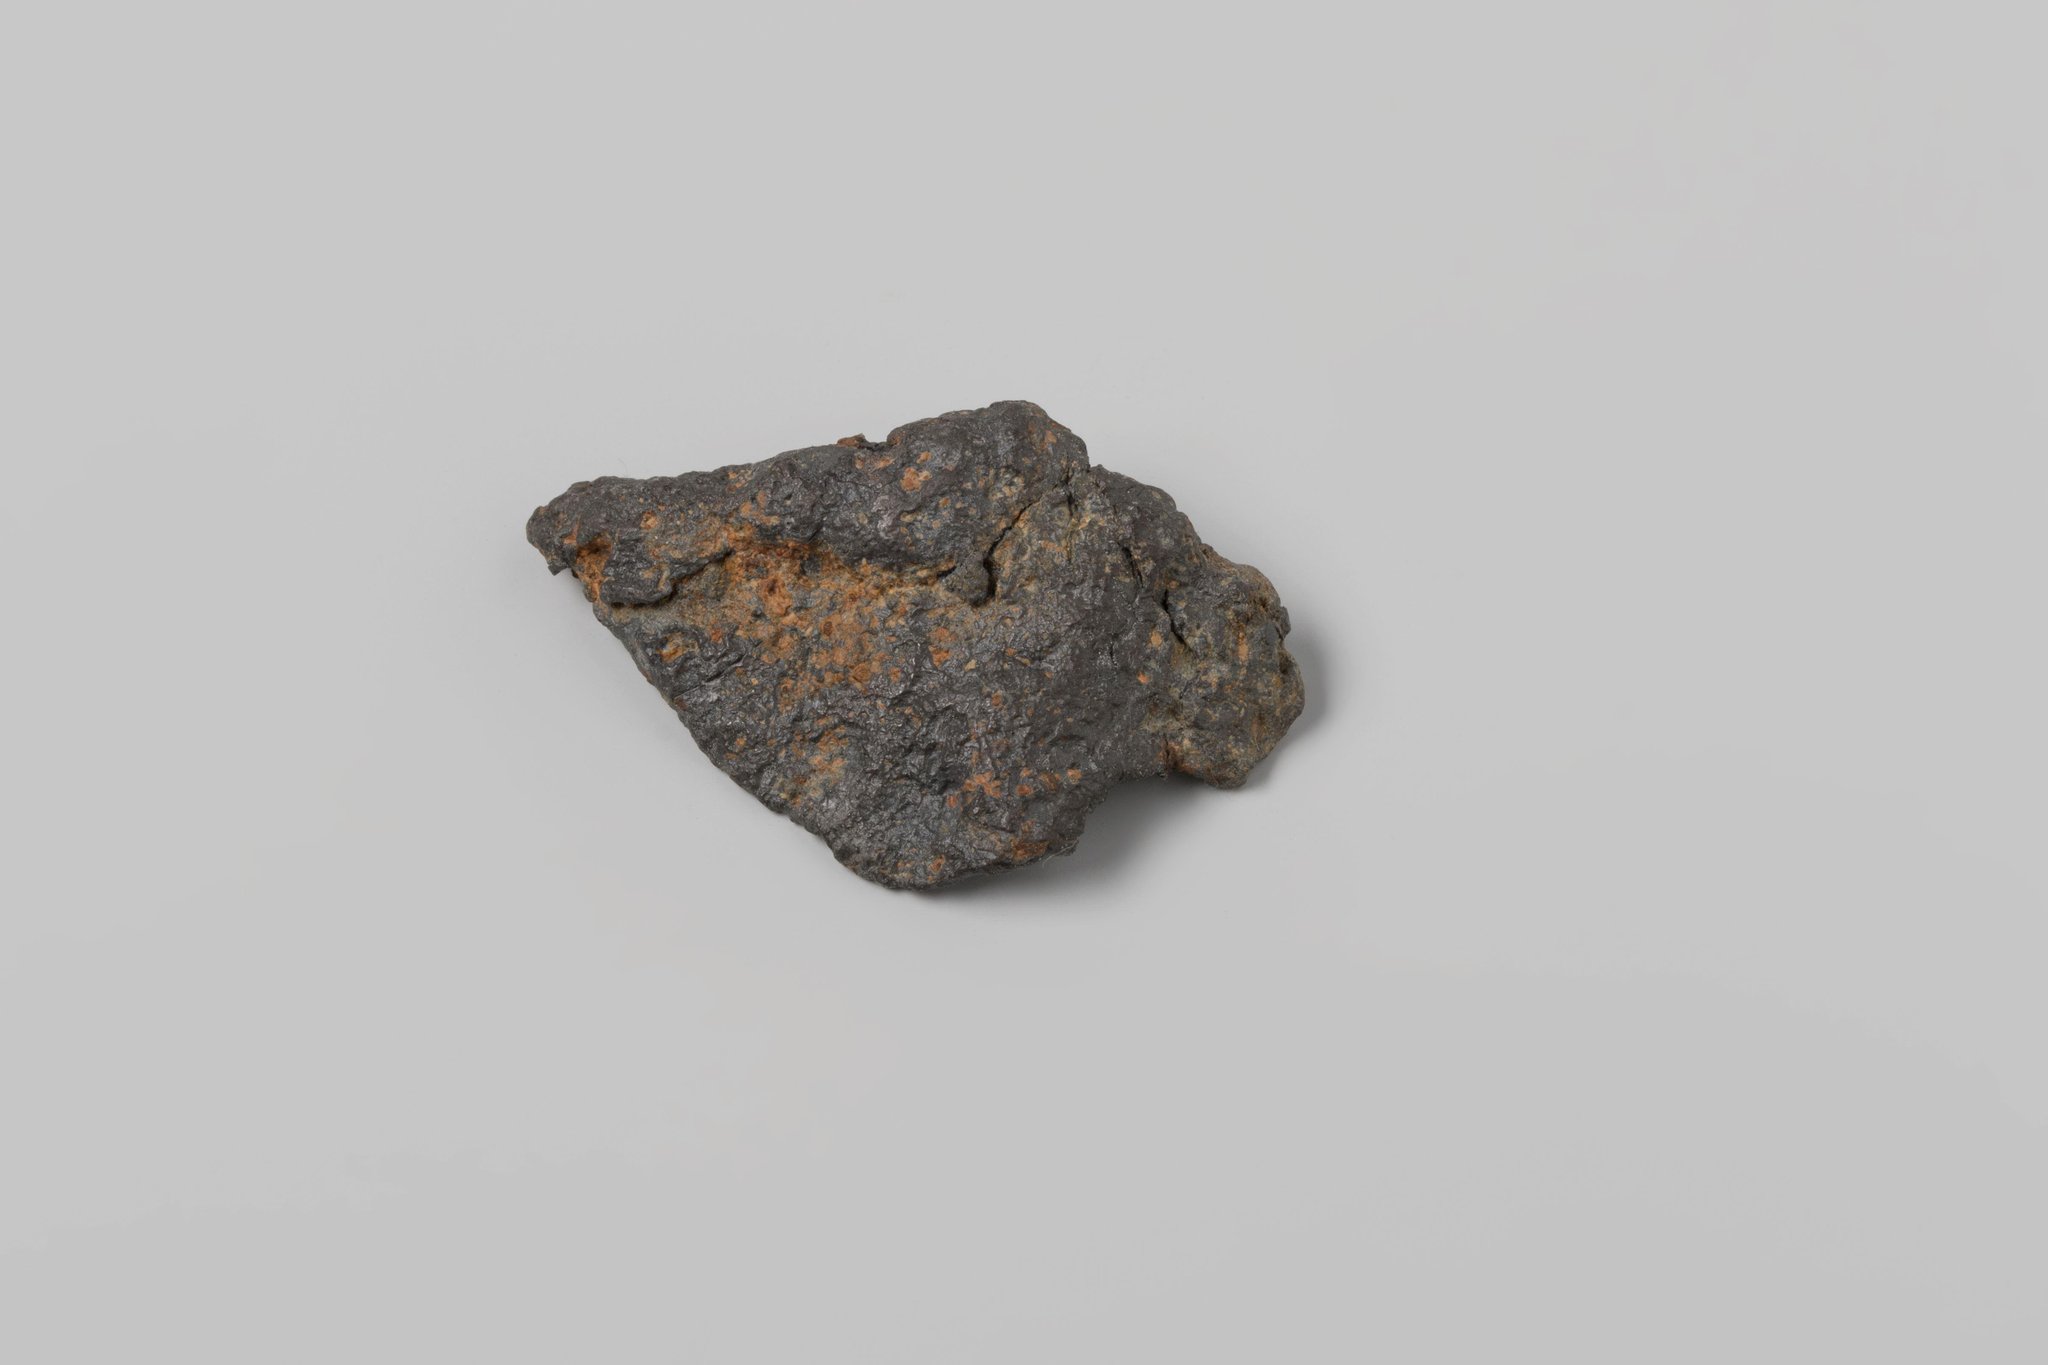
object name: fragment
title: Fragment lood uit het wrak van de Oost-Indiëvaarder Hollandia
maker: Anonymous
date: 1700-1743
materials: lead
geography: netherlands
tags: verenigde oostindische compagnie, hollandia (schip), annet